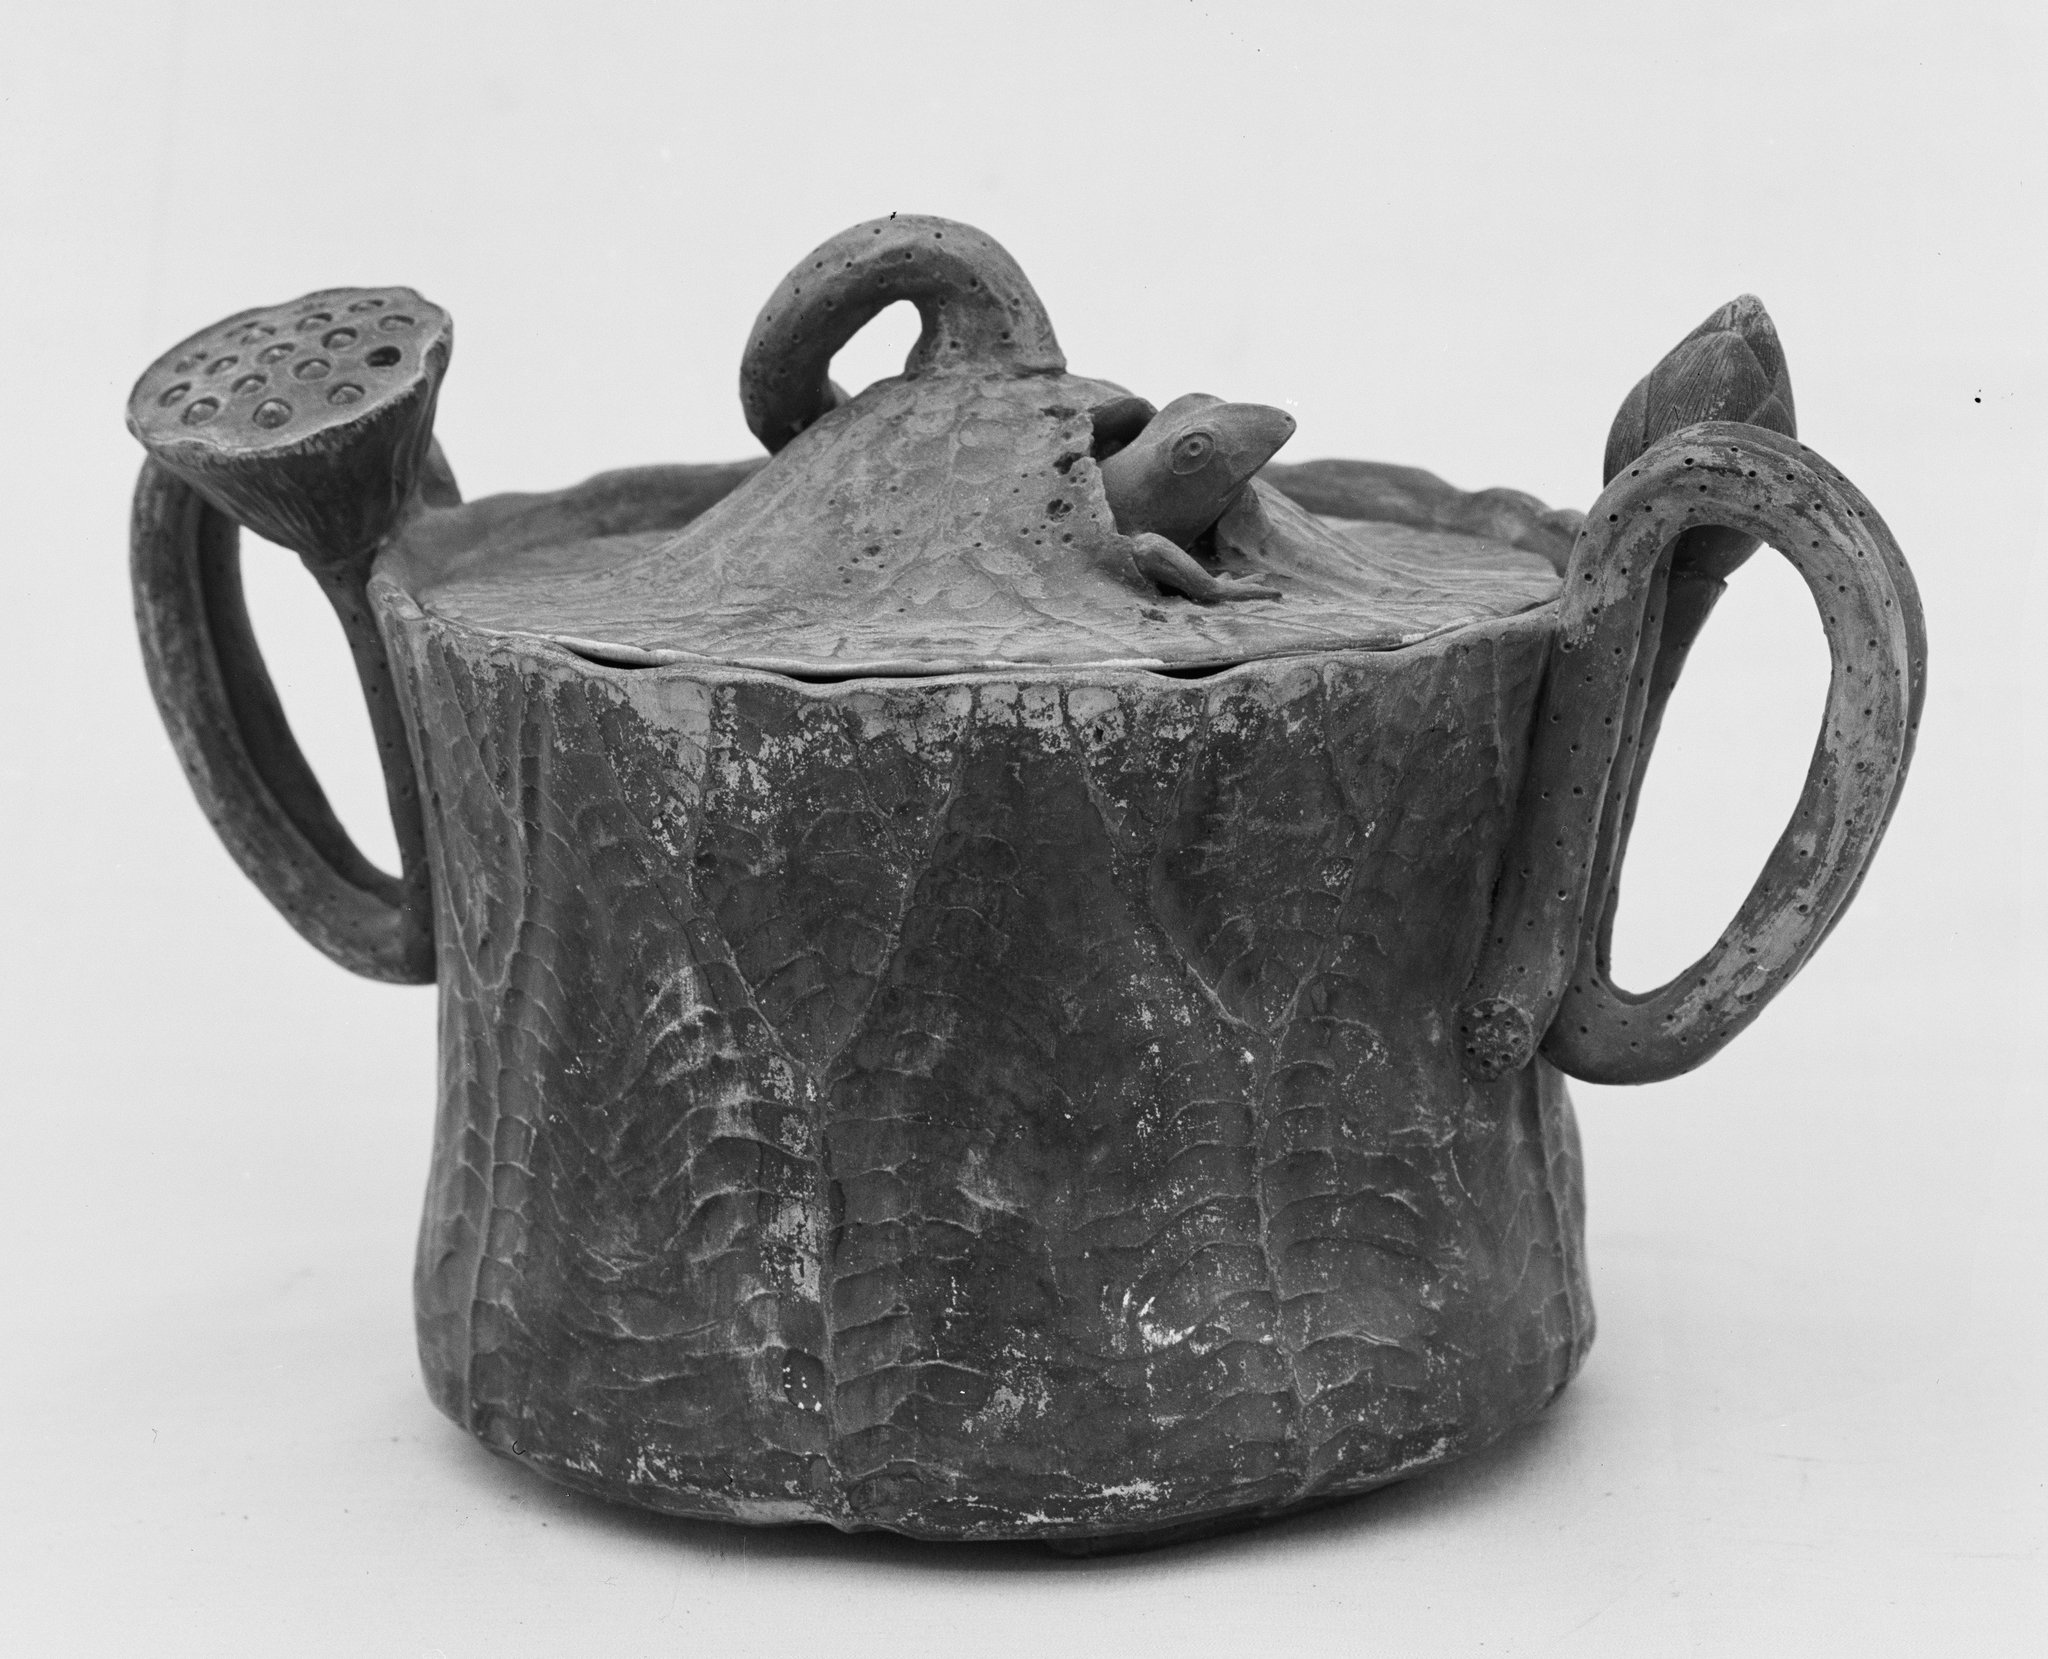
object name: teapot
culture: japanese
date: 1801-1900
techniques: glazing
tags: frogs